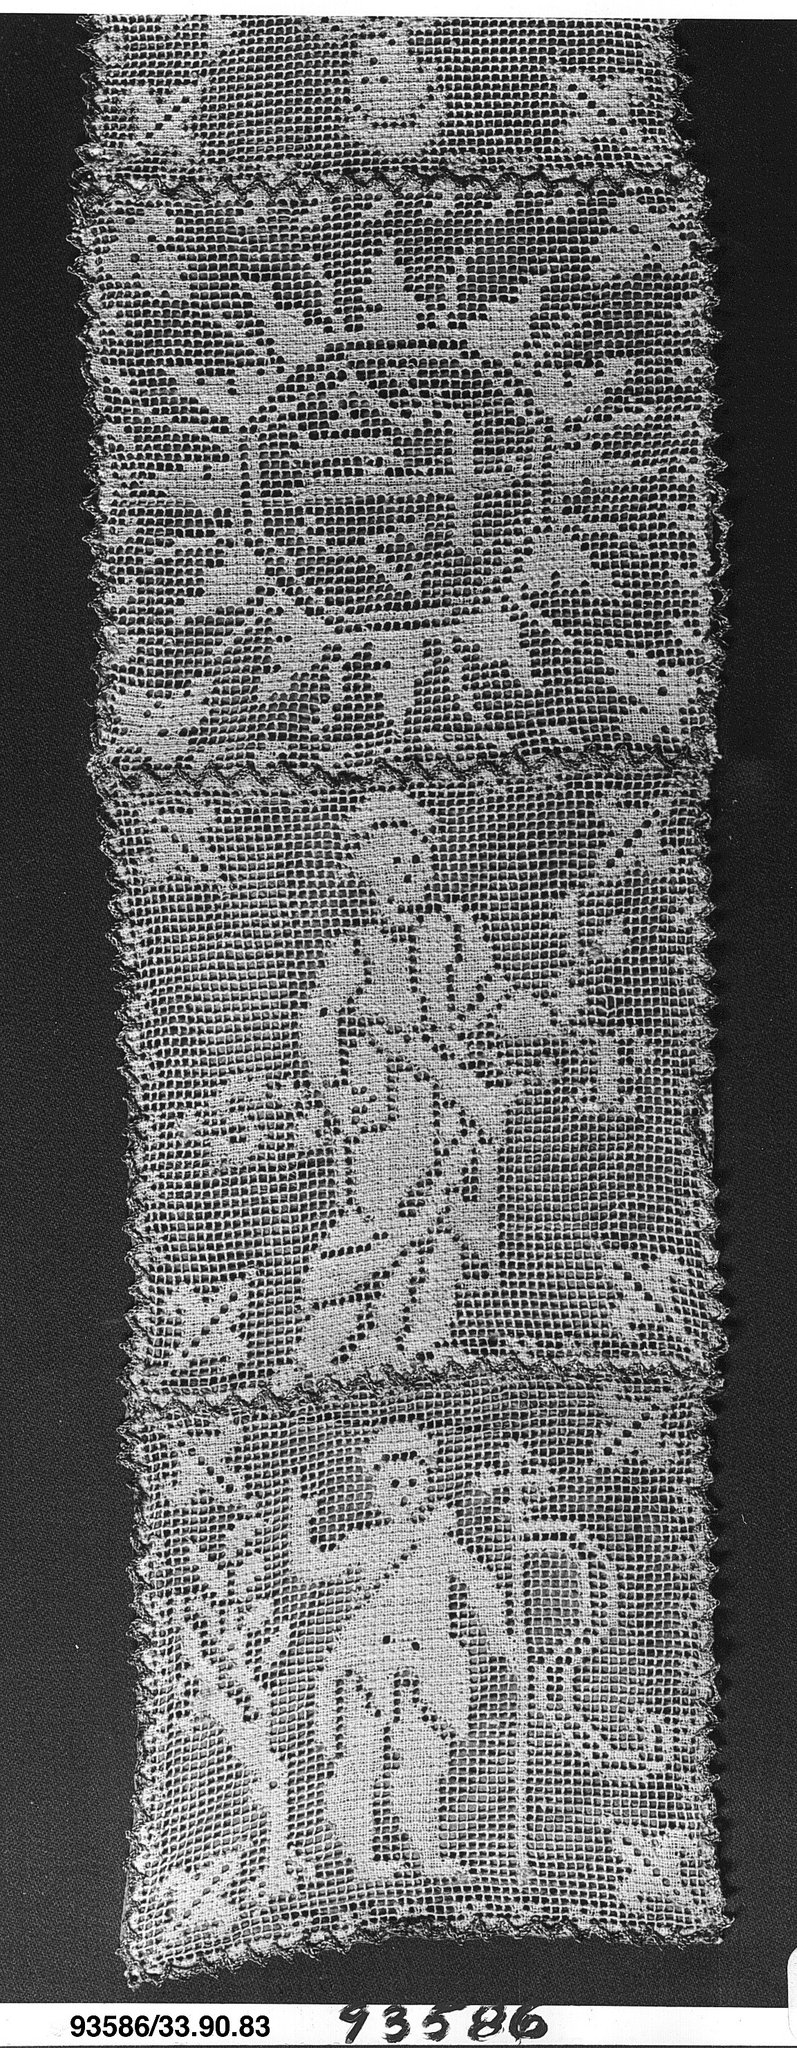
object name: strip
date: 1601-1700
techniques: embroidery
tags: human figures